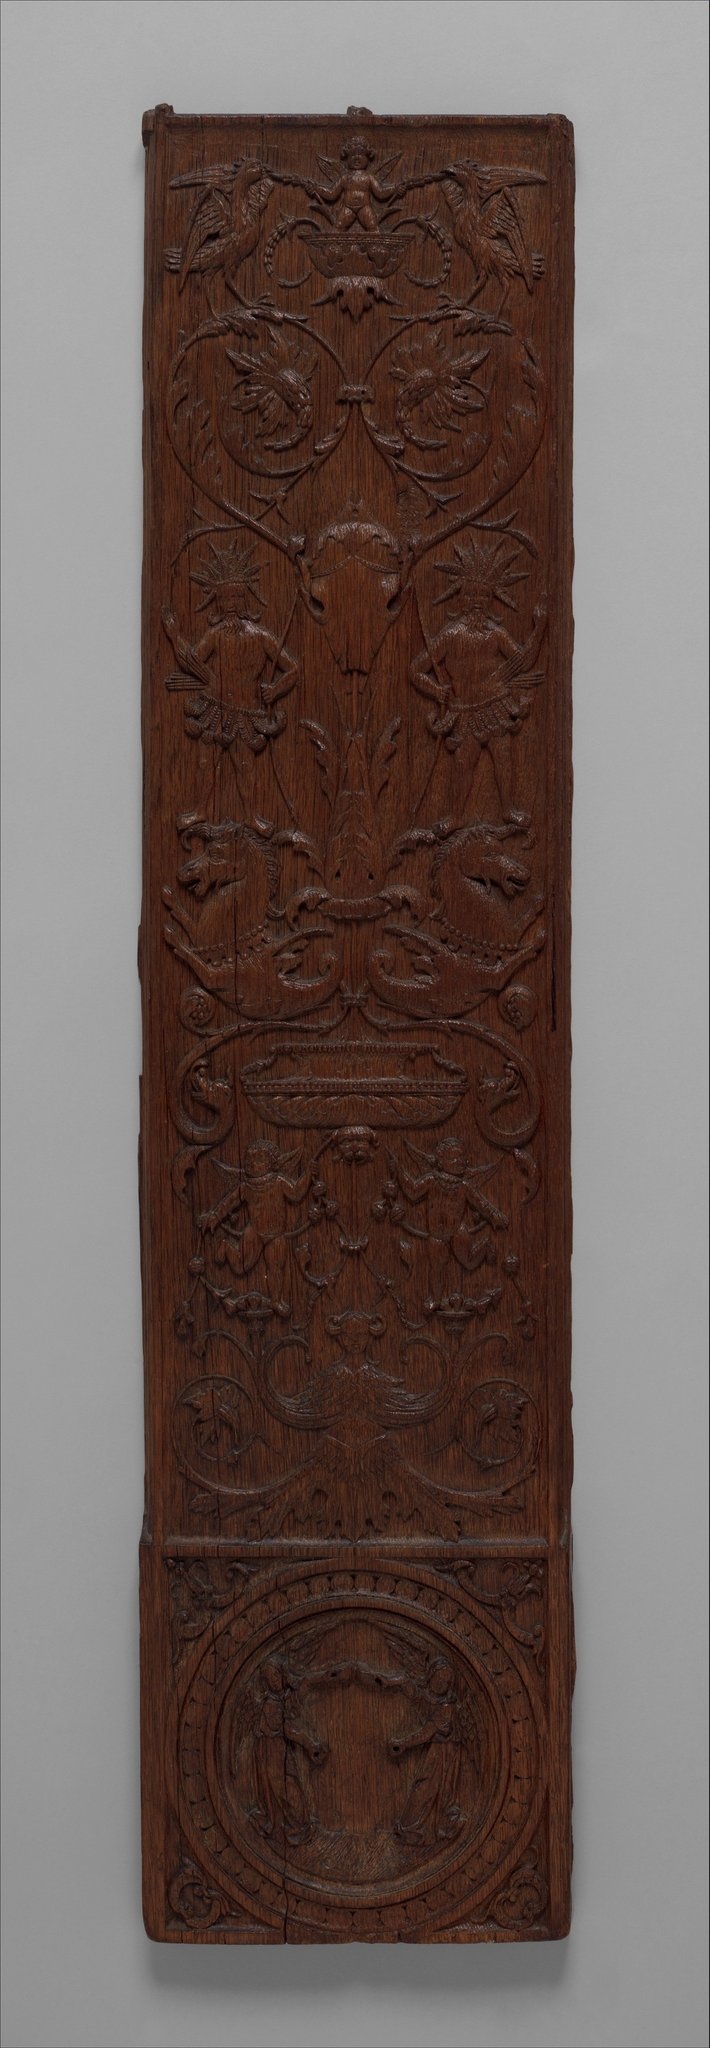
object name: choir screen panel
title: Choir screen panel (one of six)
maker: nicolas castille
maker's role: maker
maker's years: 1503-1521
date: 1508-1510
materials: wood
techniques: carving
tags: human figures,birds,horses